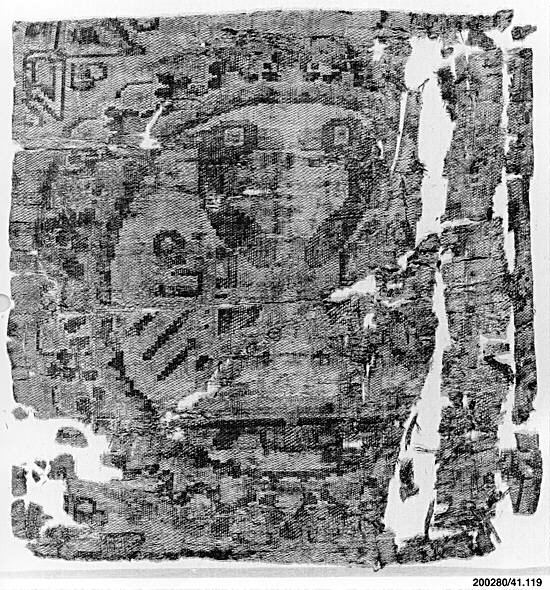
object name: textile fragment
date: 701-900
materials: silk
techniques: tapestry, weave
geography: iran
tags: birds